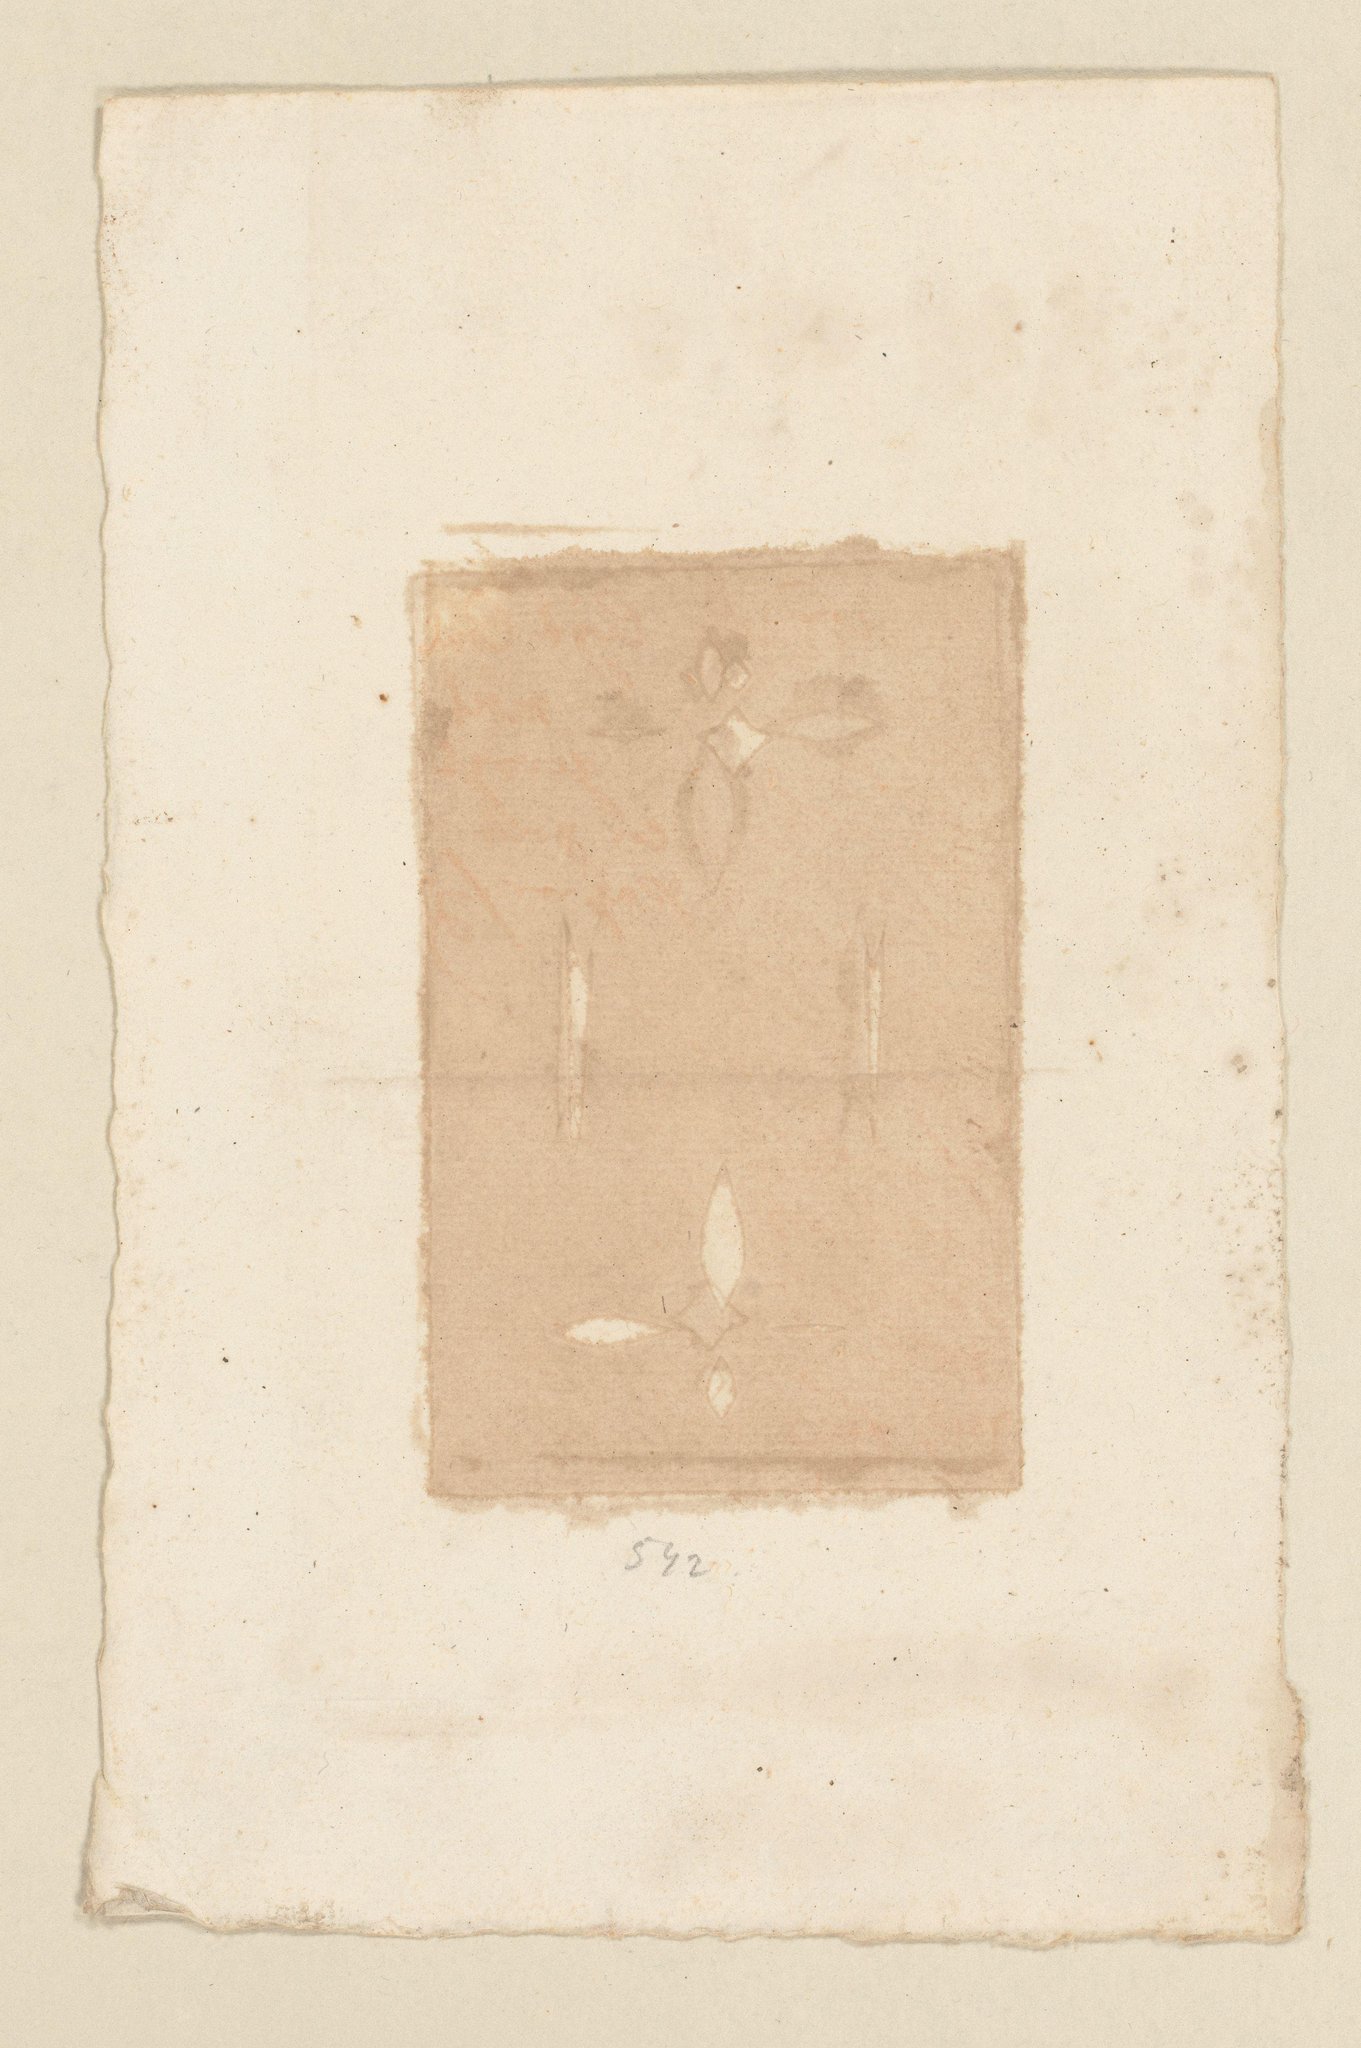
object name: print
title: Proef met uitsparingen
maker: cornelis ploos van amstel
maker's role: draughtsman, print maker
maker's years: 1726-1798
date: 1736-1798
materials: oil, paper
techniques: woodcut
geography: amsterdam